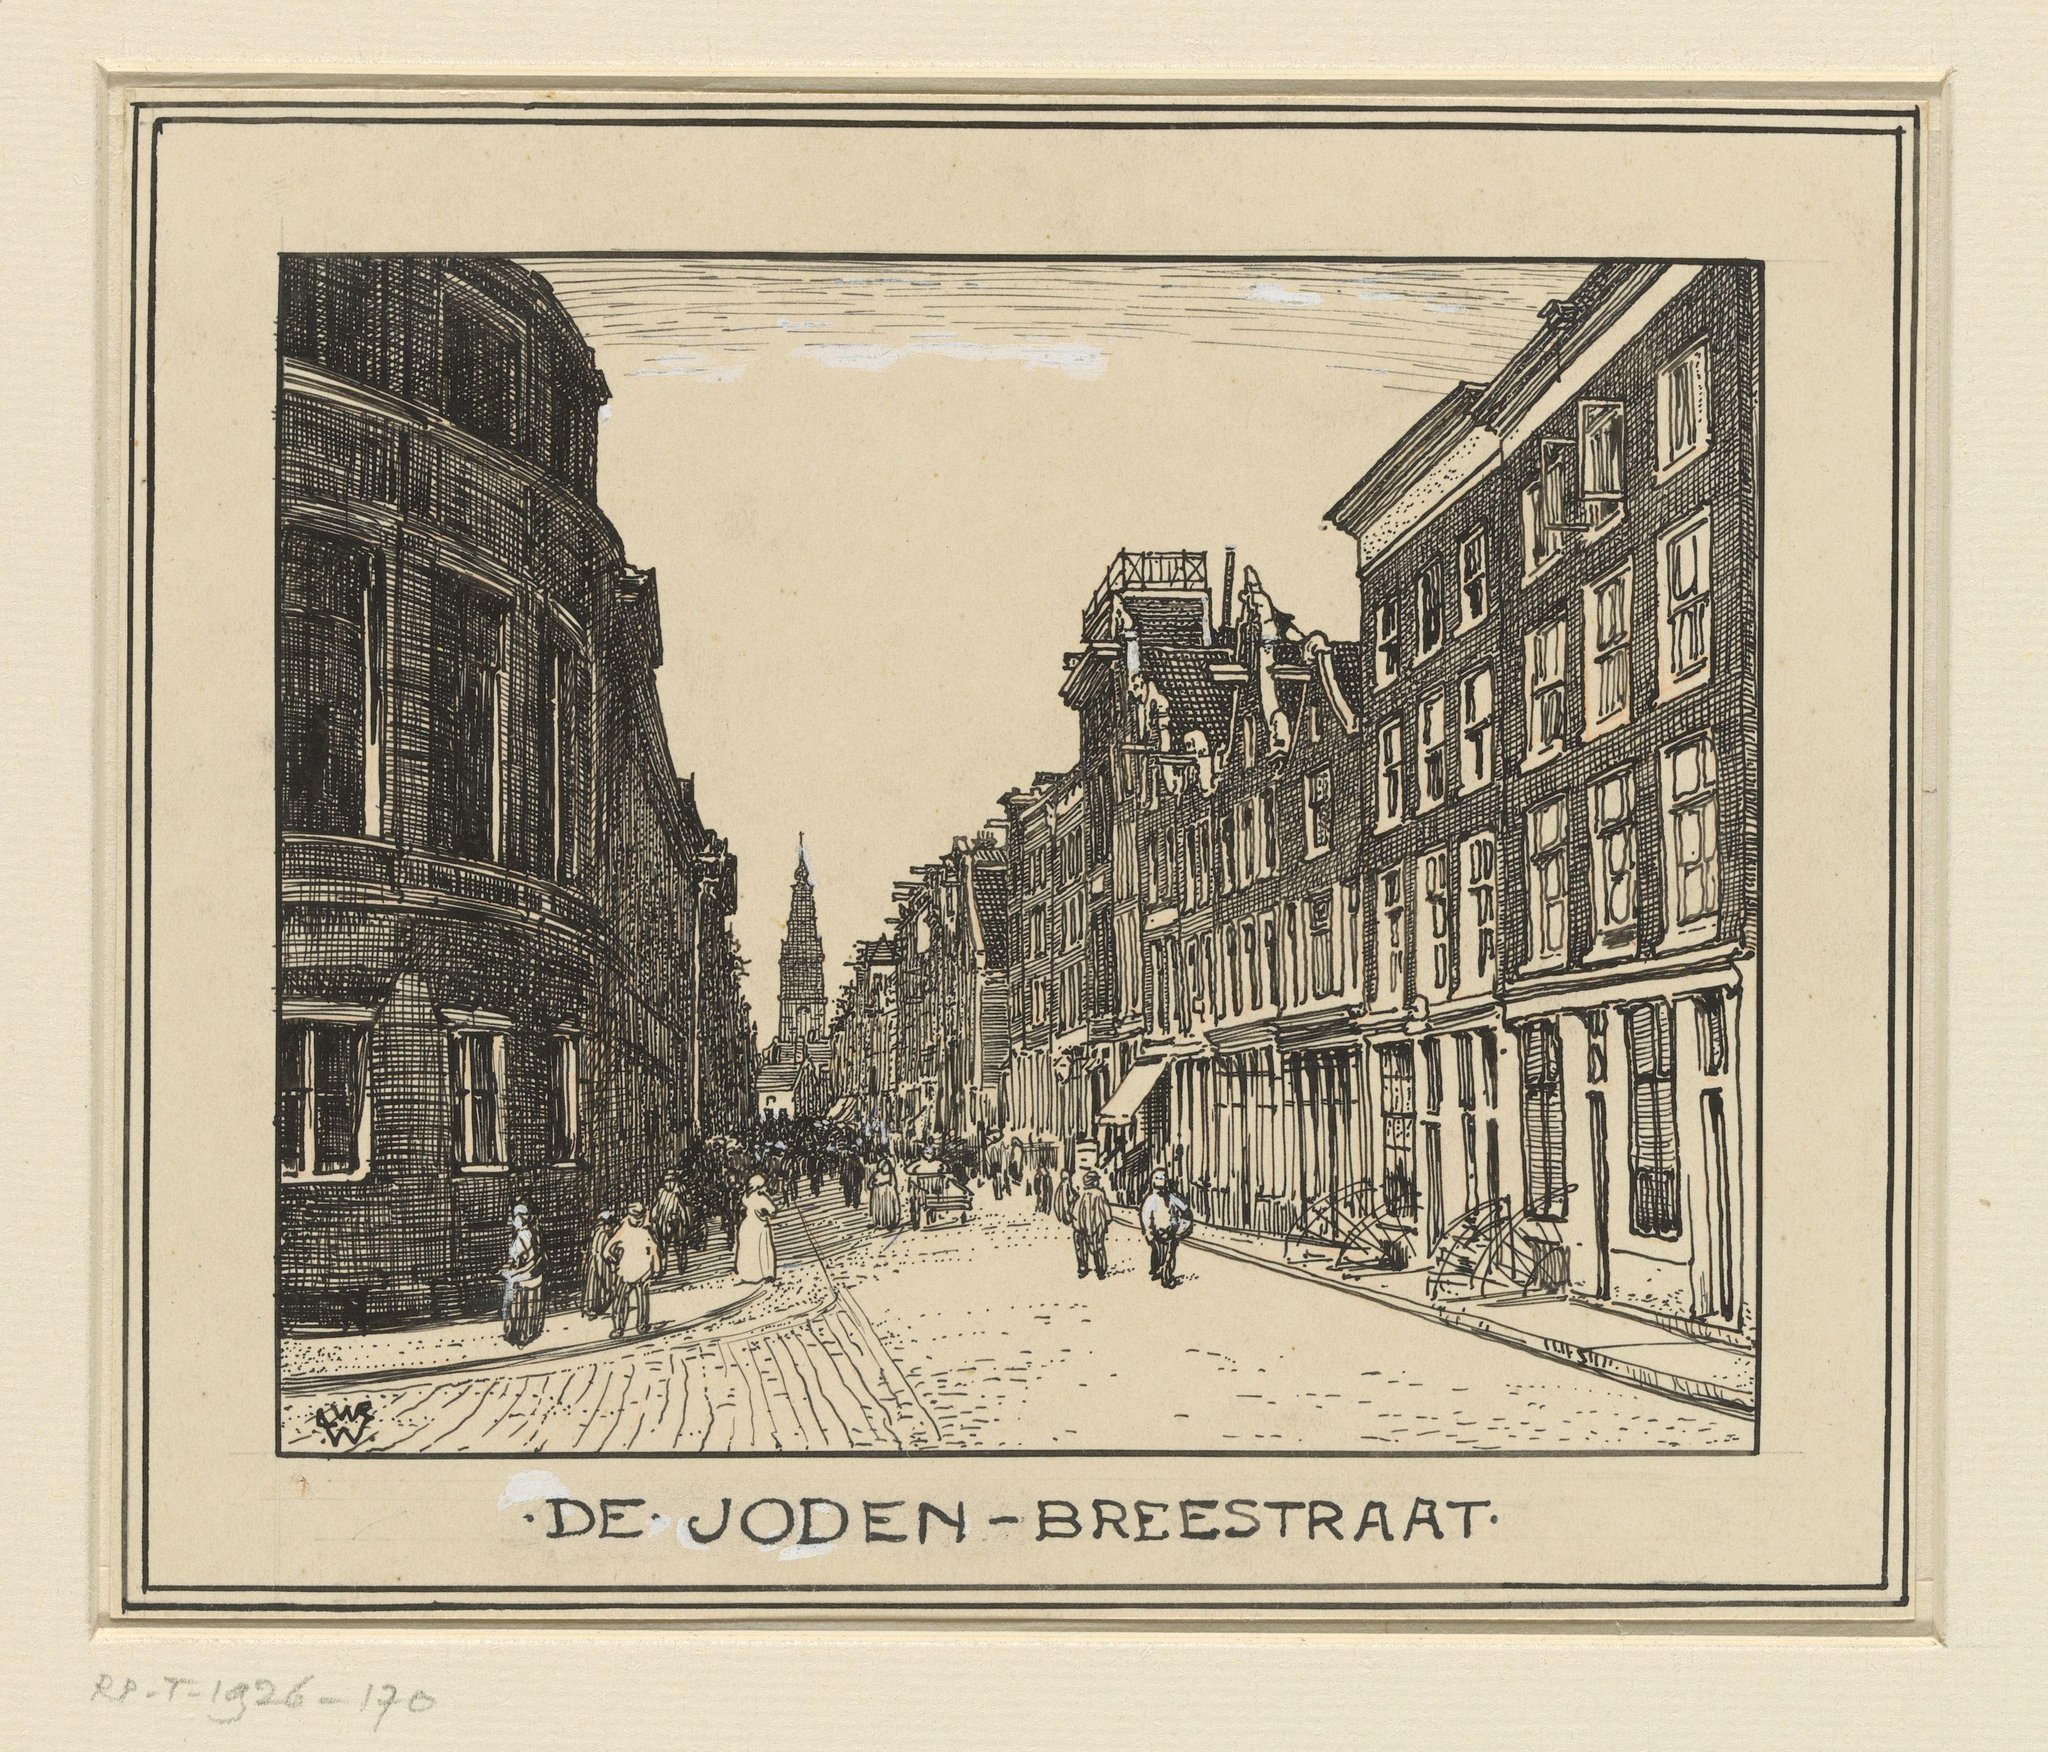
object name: drawing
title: De Joden Breestraat te Amsterdam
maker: willem wenckebach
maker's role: designer, draughtsman, painter, print maker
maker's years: 1860-1937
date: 1870-1926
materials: paint, ink, paper, pencil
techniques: pen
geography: amsterdam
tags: street